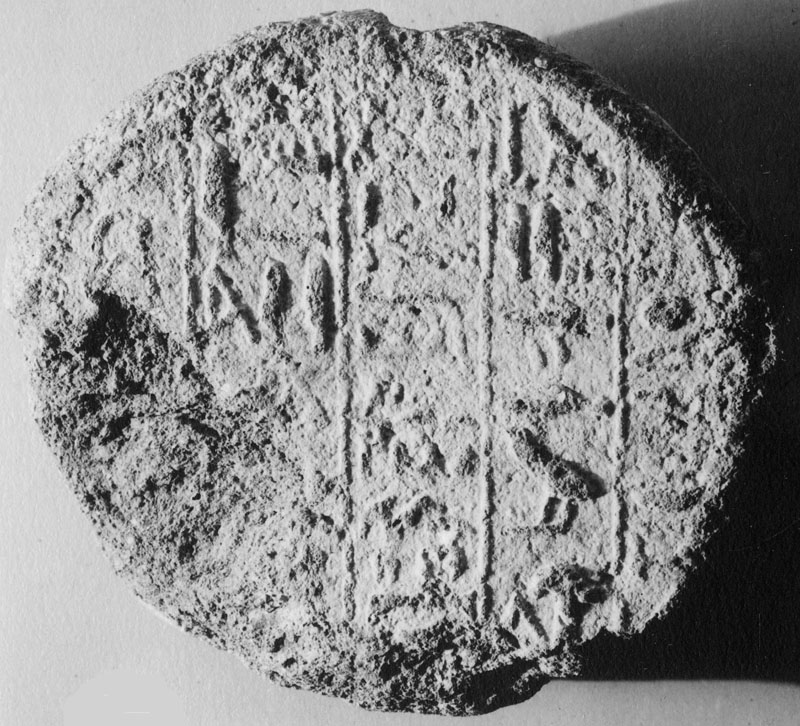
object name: cone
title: Funerary Cone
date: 1550-1295 BCE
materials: pottery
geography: egypt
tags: hieroglyphs